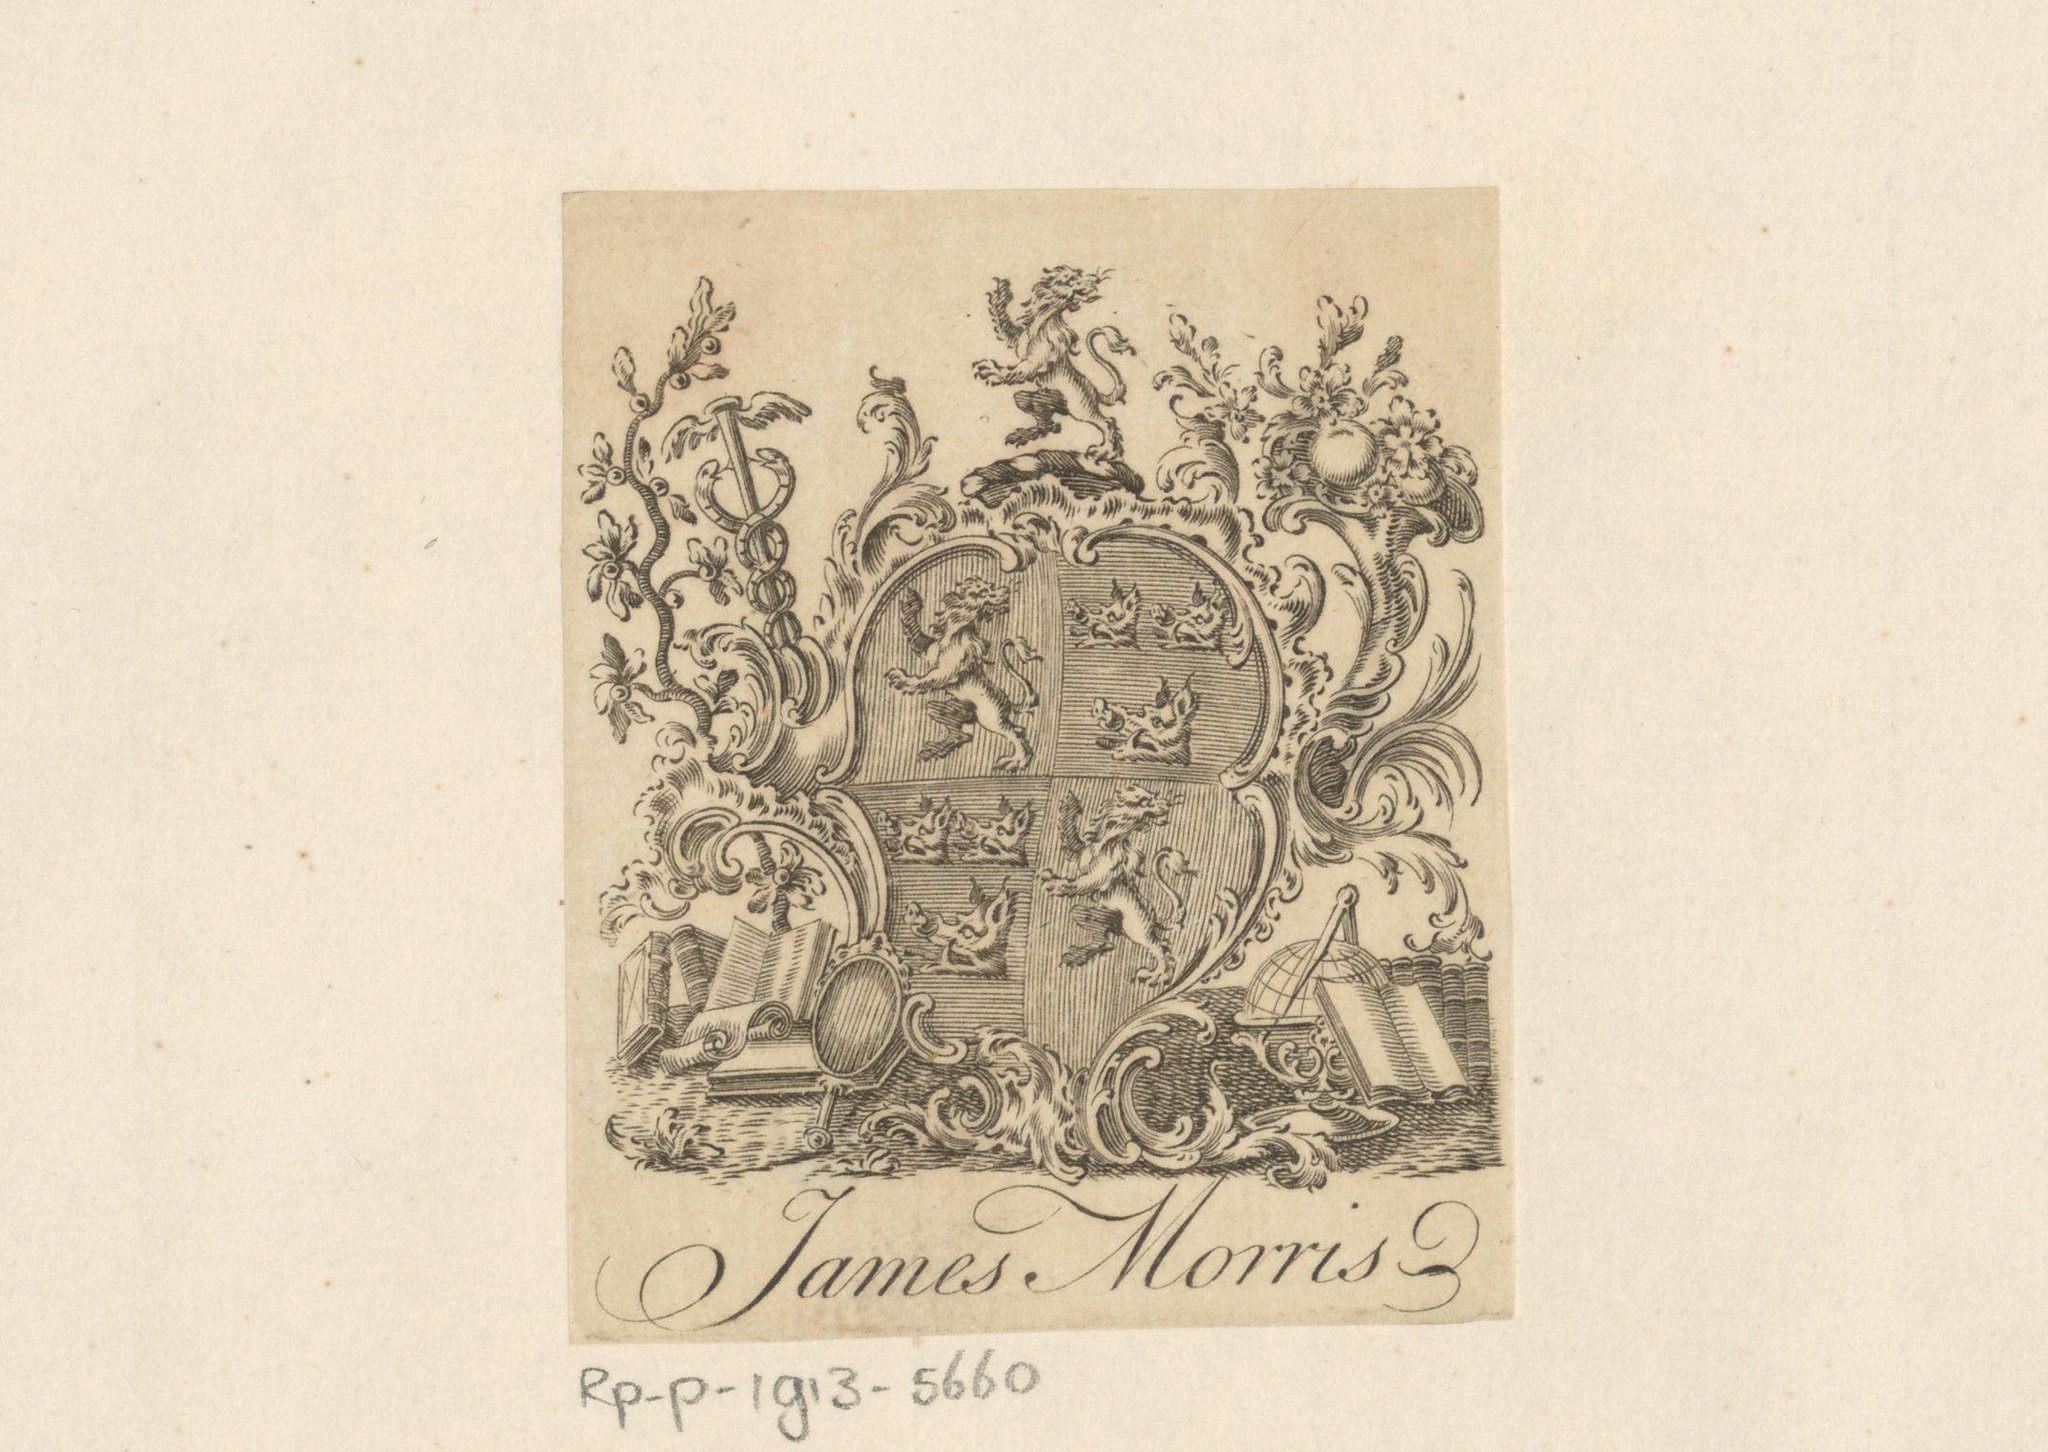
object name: bookplate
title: Ex libris van James Morris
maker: Anonymous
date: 1750-1799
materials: paper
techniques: engraving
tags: armorial bearing, heraldry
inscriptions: collector's mark: Lugt 2760, collector's mark: Lugt 2233